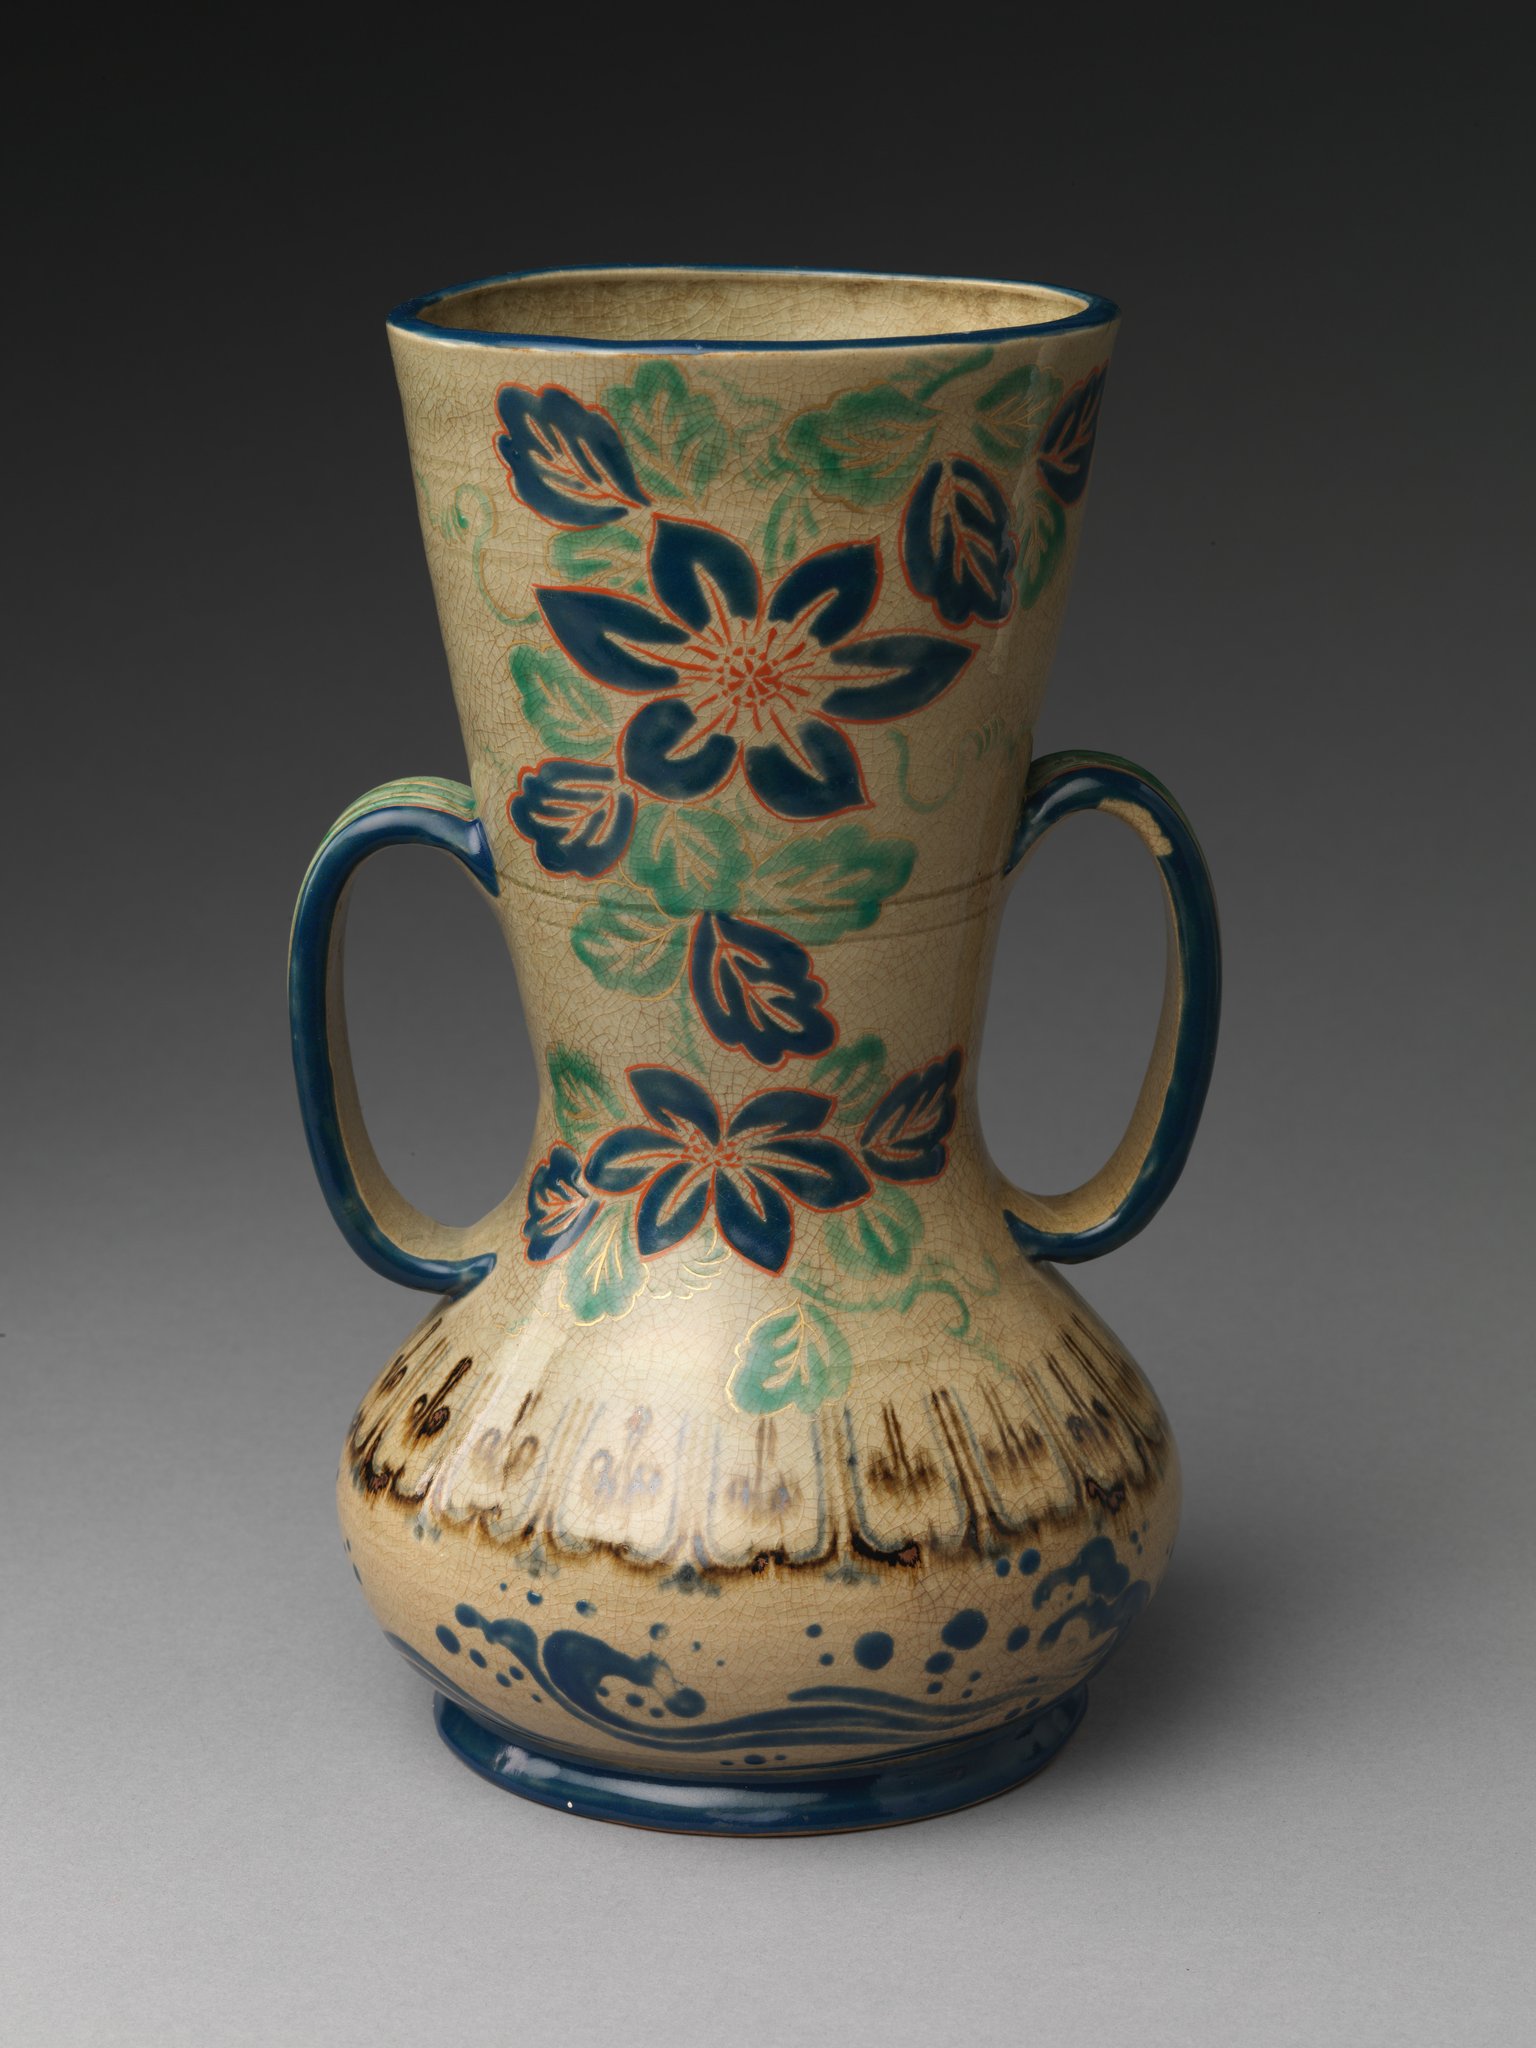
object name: vase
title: Vase with handles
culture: japanese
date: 1701-1800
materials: enamel, stoneware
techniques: polychrome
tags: flowers,leaves